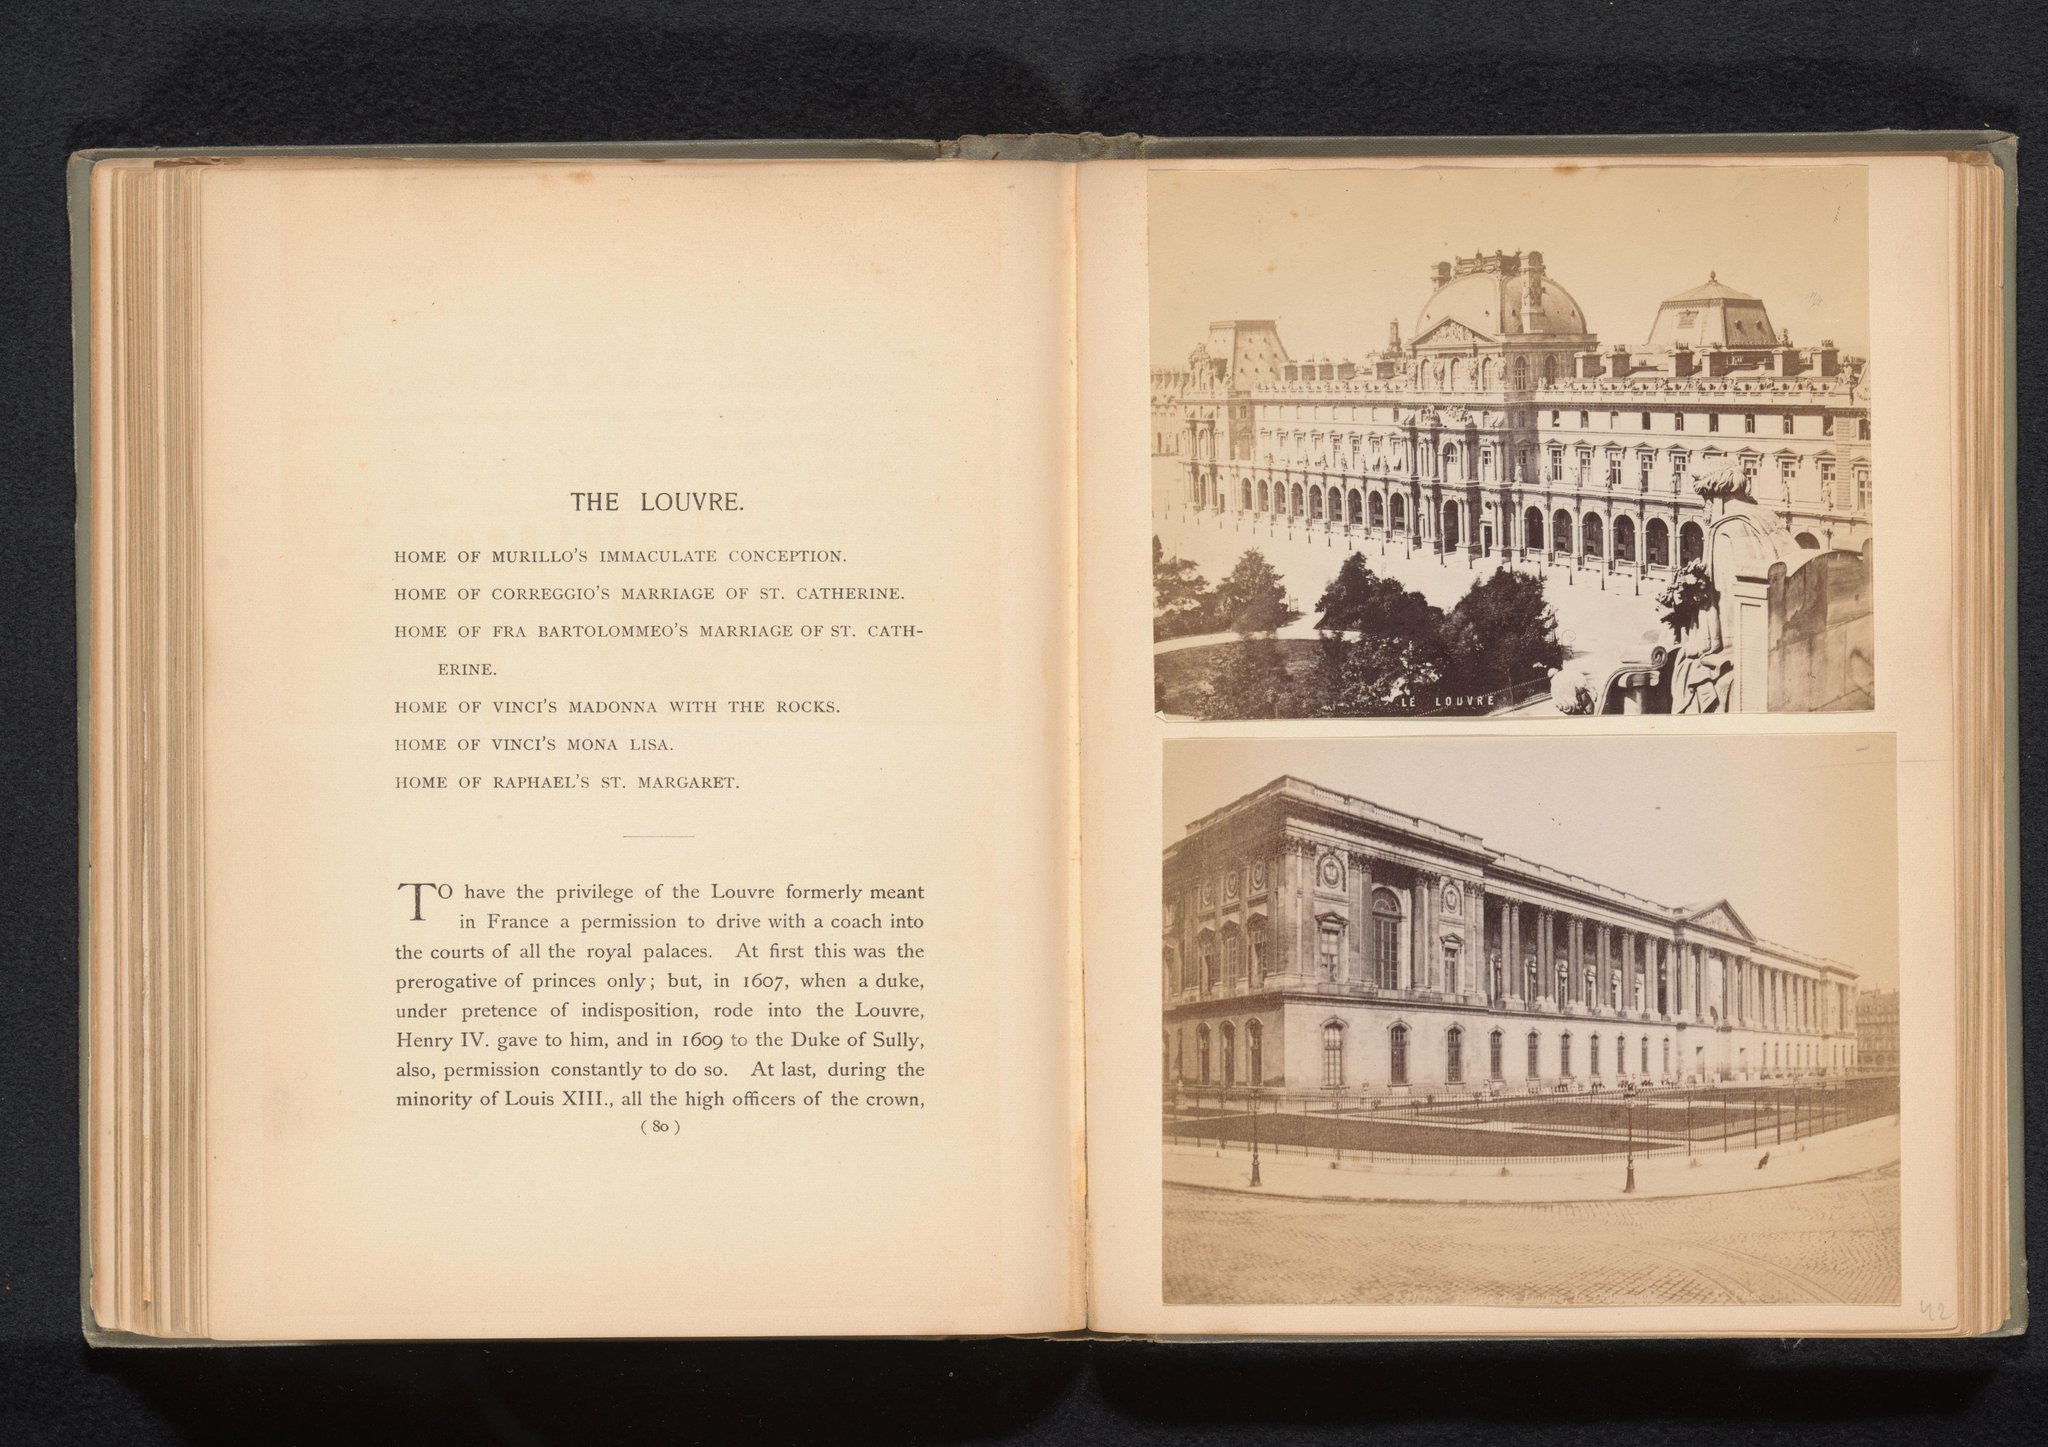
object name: photograph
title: Twee exterieurs van het Musée du Louvre te Parijs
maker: Anonymous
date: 1882-1887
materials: photographic support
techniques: albumen print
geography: paris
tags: permanent exhibition, museum, façade (of house or building)